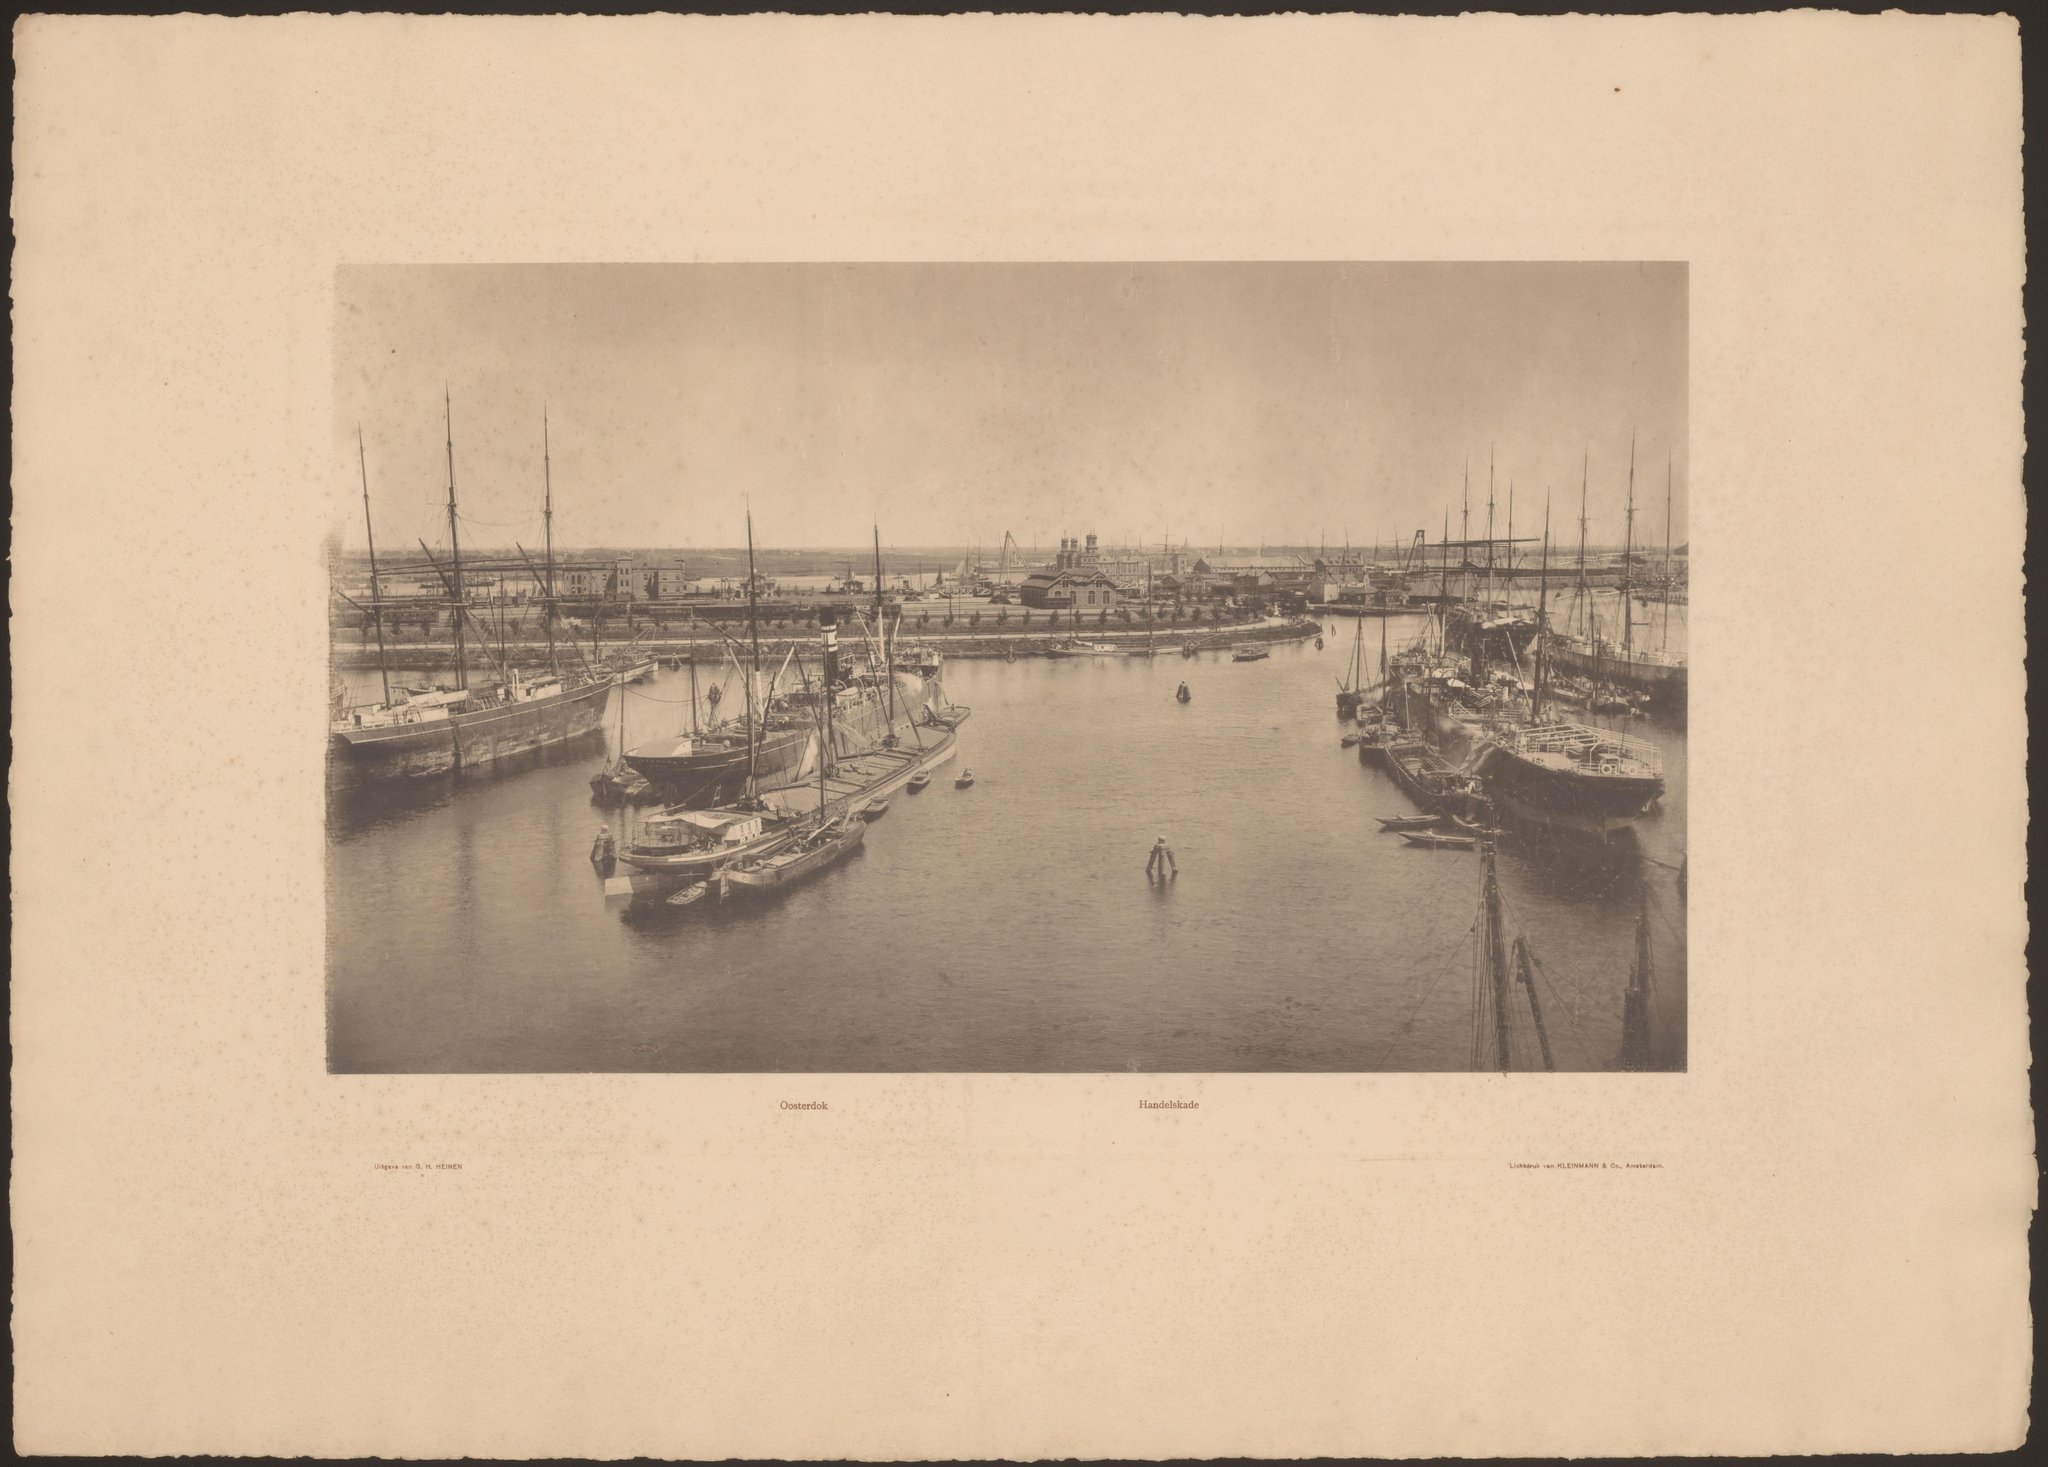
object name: photomechanical print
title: Panorama's en Stadsgezichten van Amsterdam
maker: gerrit hendricus heinen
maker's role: painter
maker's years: 1851-1930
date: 1892-1930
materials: paper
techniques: photograph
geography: amsterdam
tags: river, ships (in general) - cc - more than one ship, prospect of city, town panorama, silhouette of city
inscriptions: check stamp: ‘G.H. Heinen Amsterdam / Schilder & Fotograaf’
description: Onderwerpsrubriek binnen de Atlas Amsterdam: Panorama's en verzamelprenten.